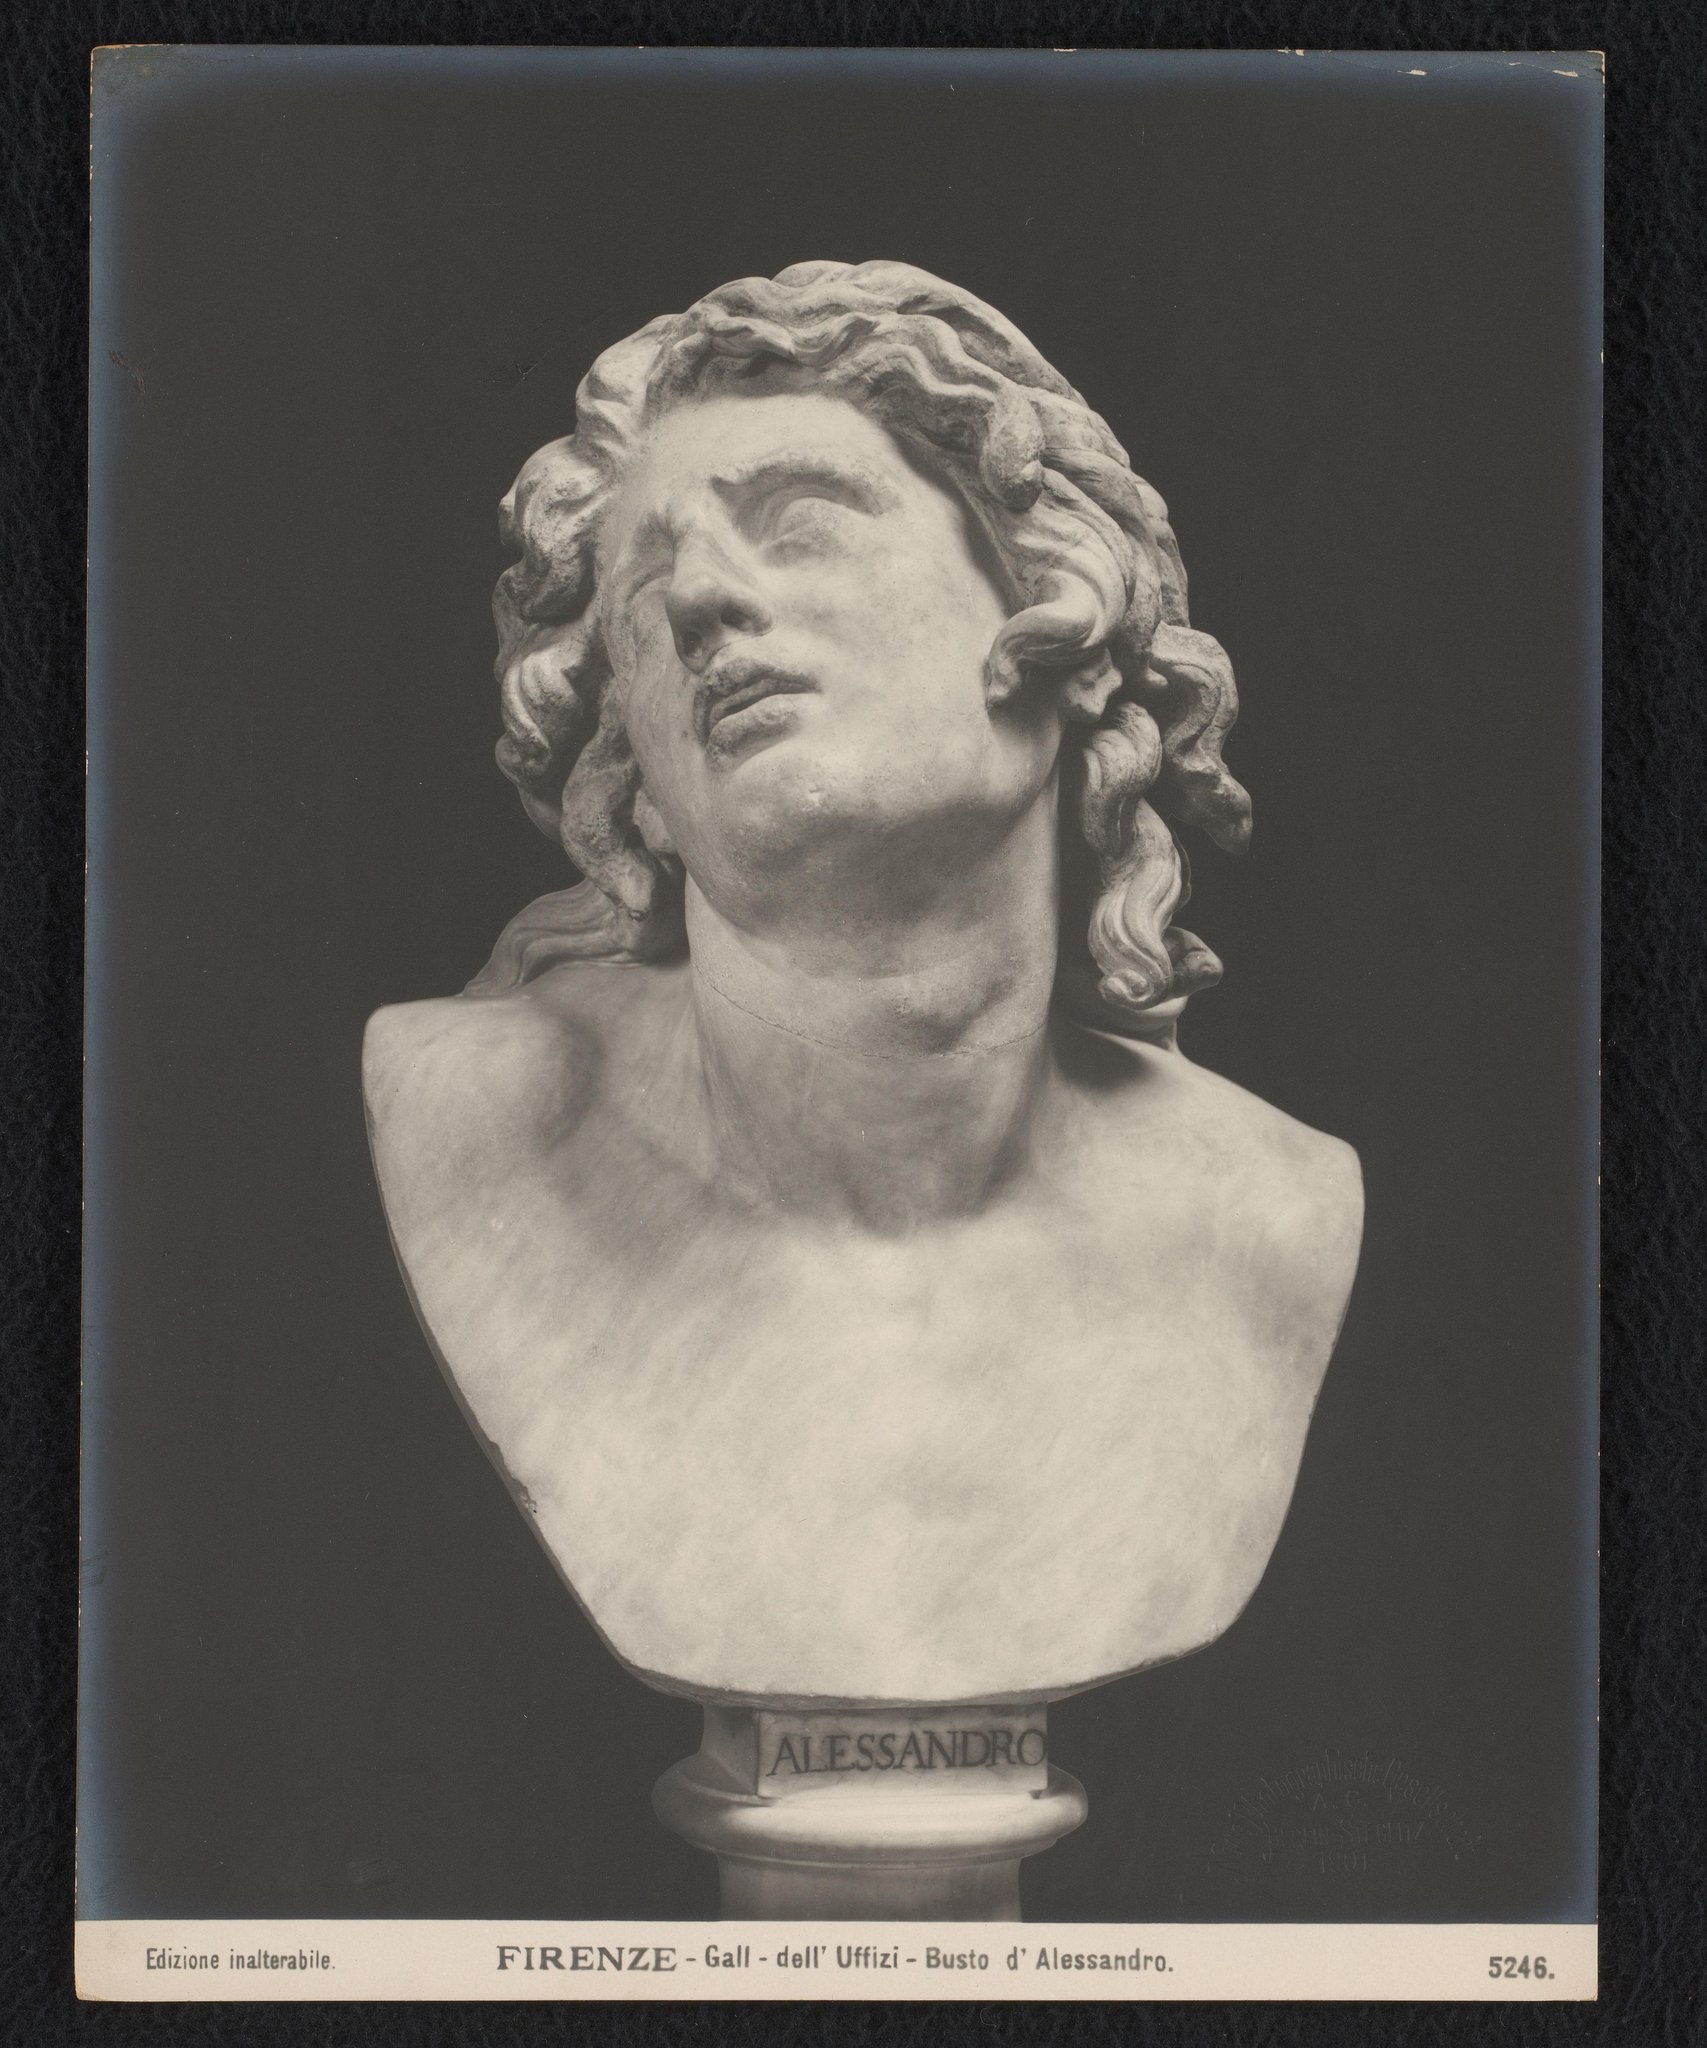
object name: photograph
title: Firenze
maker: Anonymous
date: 1901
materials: paper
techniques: gelatin silver print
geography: berlin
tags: (story of) alexander the great, piece of sculpture, reproduction of a piece of sculpture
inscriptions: collector's mark: ‘RIJKS SCHOOL VOOR KUNSTNIJVERHEID/ GROEP’, number: ‘5246.’, inscription: ‘Edizione inalterabile.’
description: Deze foto maakt deel uit van een omslag.